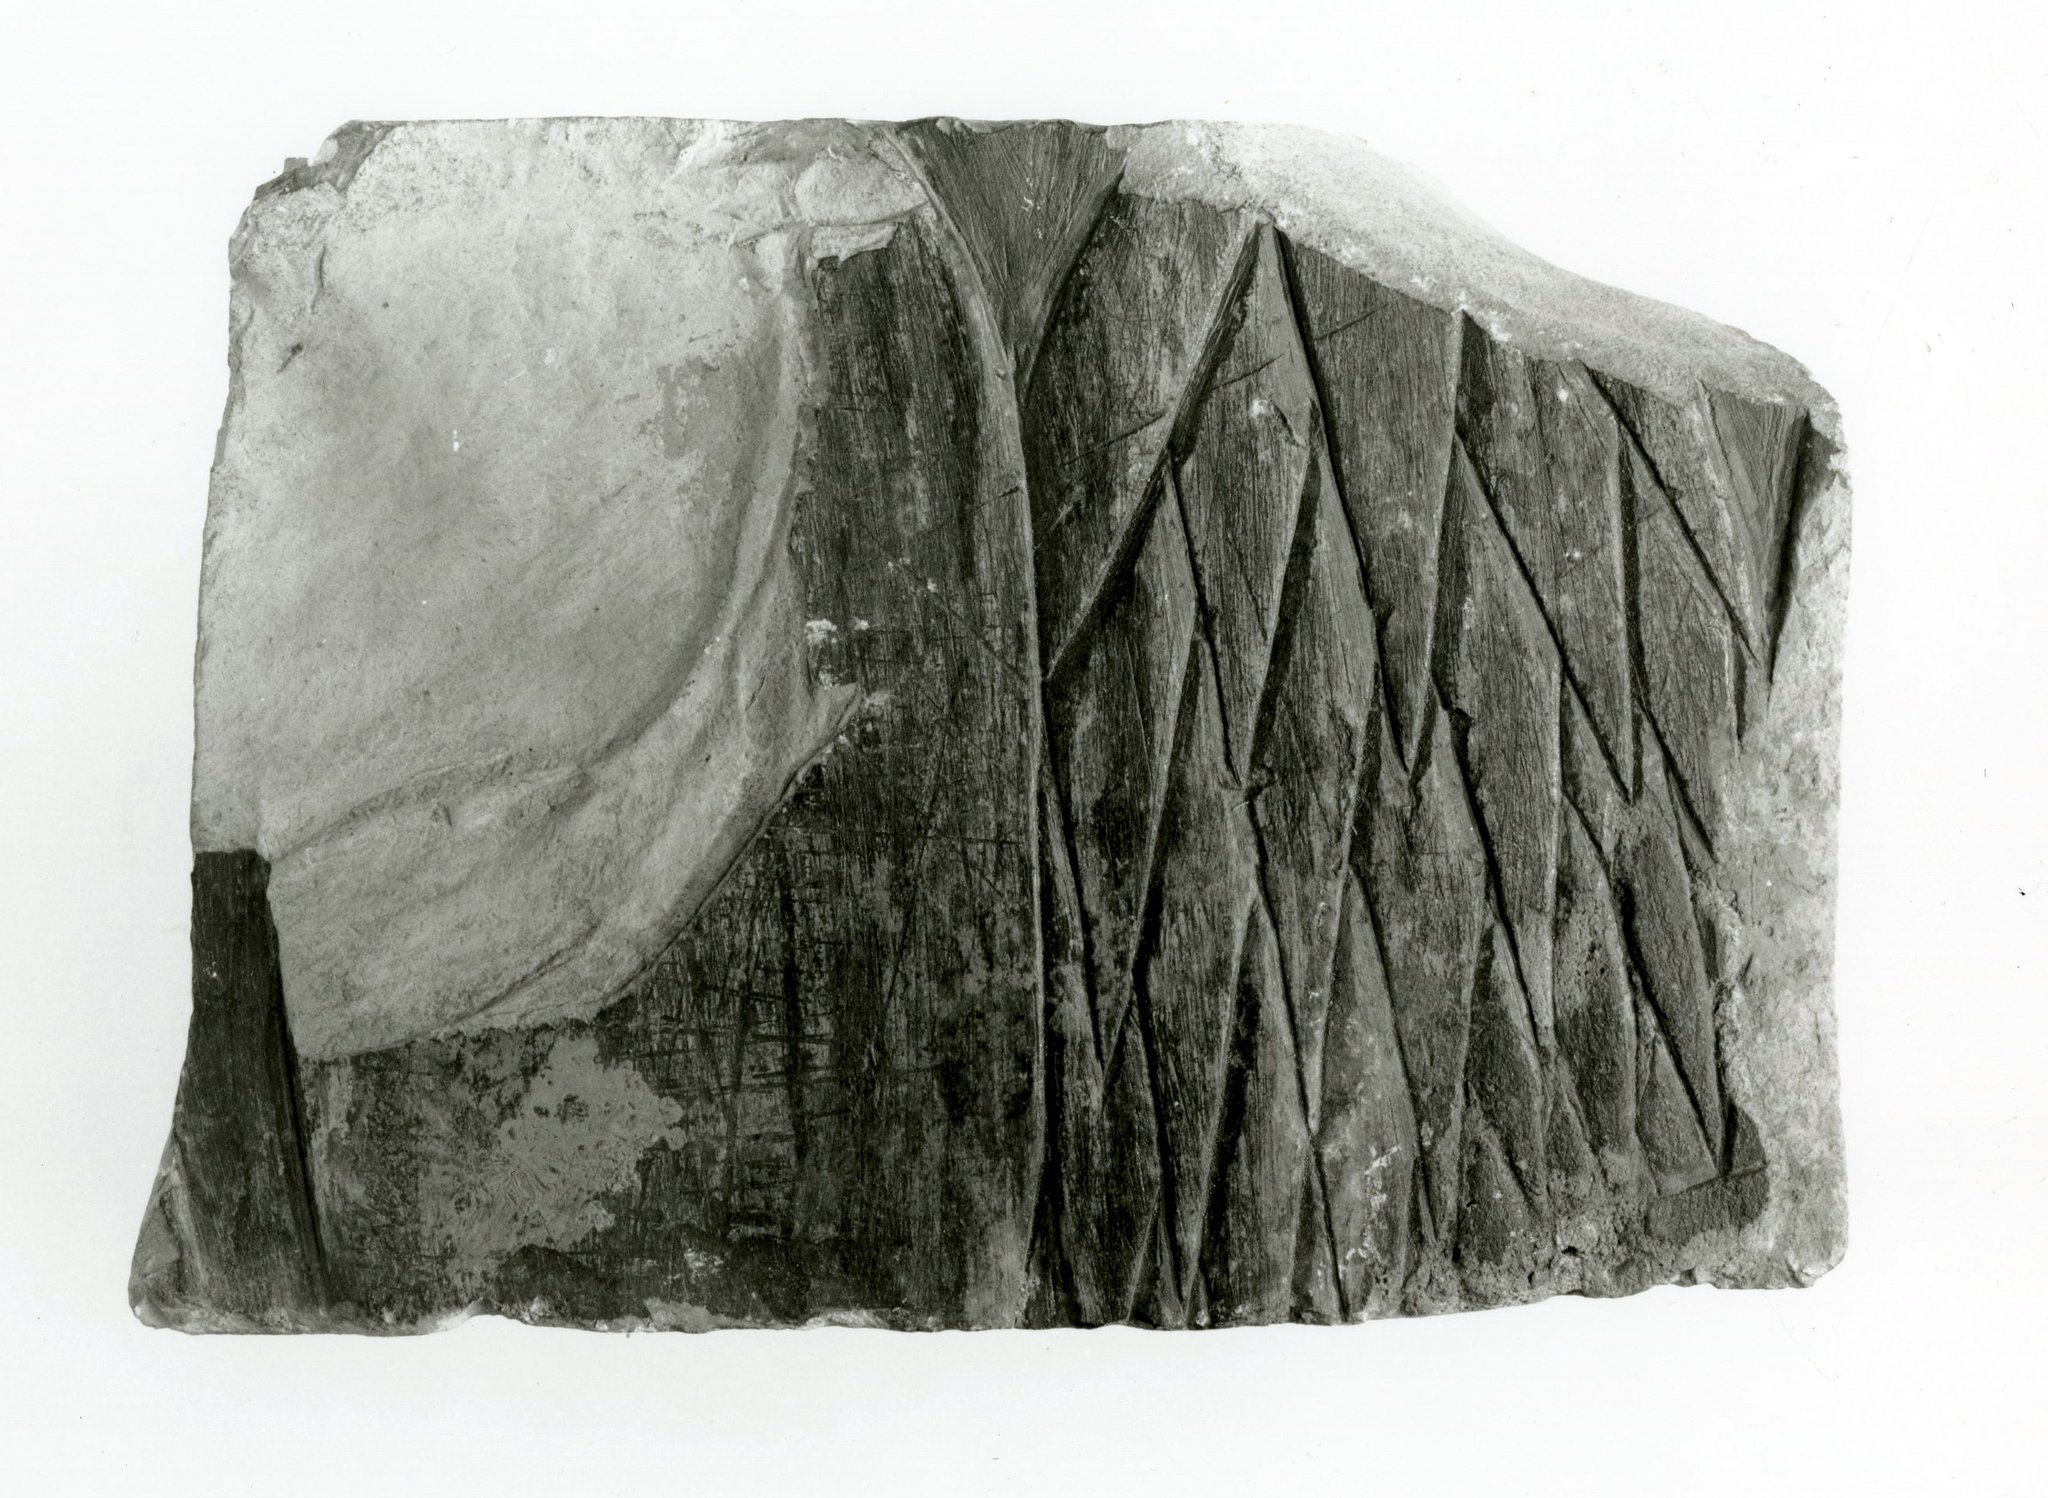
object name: relief, tomb of nespekashuty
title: Raised relief fragment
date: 664-610 BCE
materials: limestone, varnish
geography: egypt